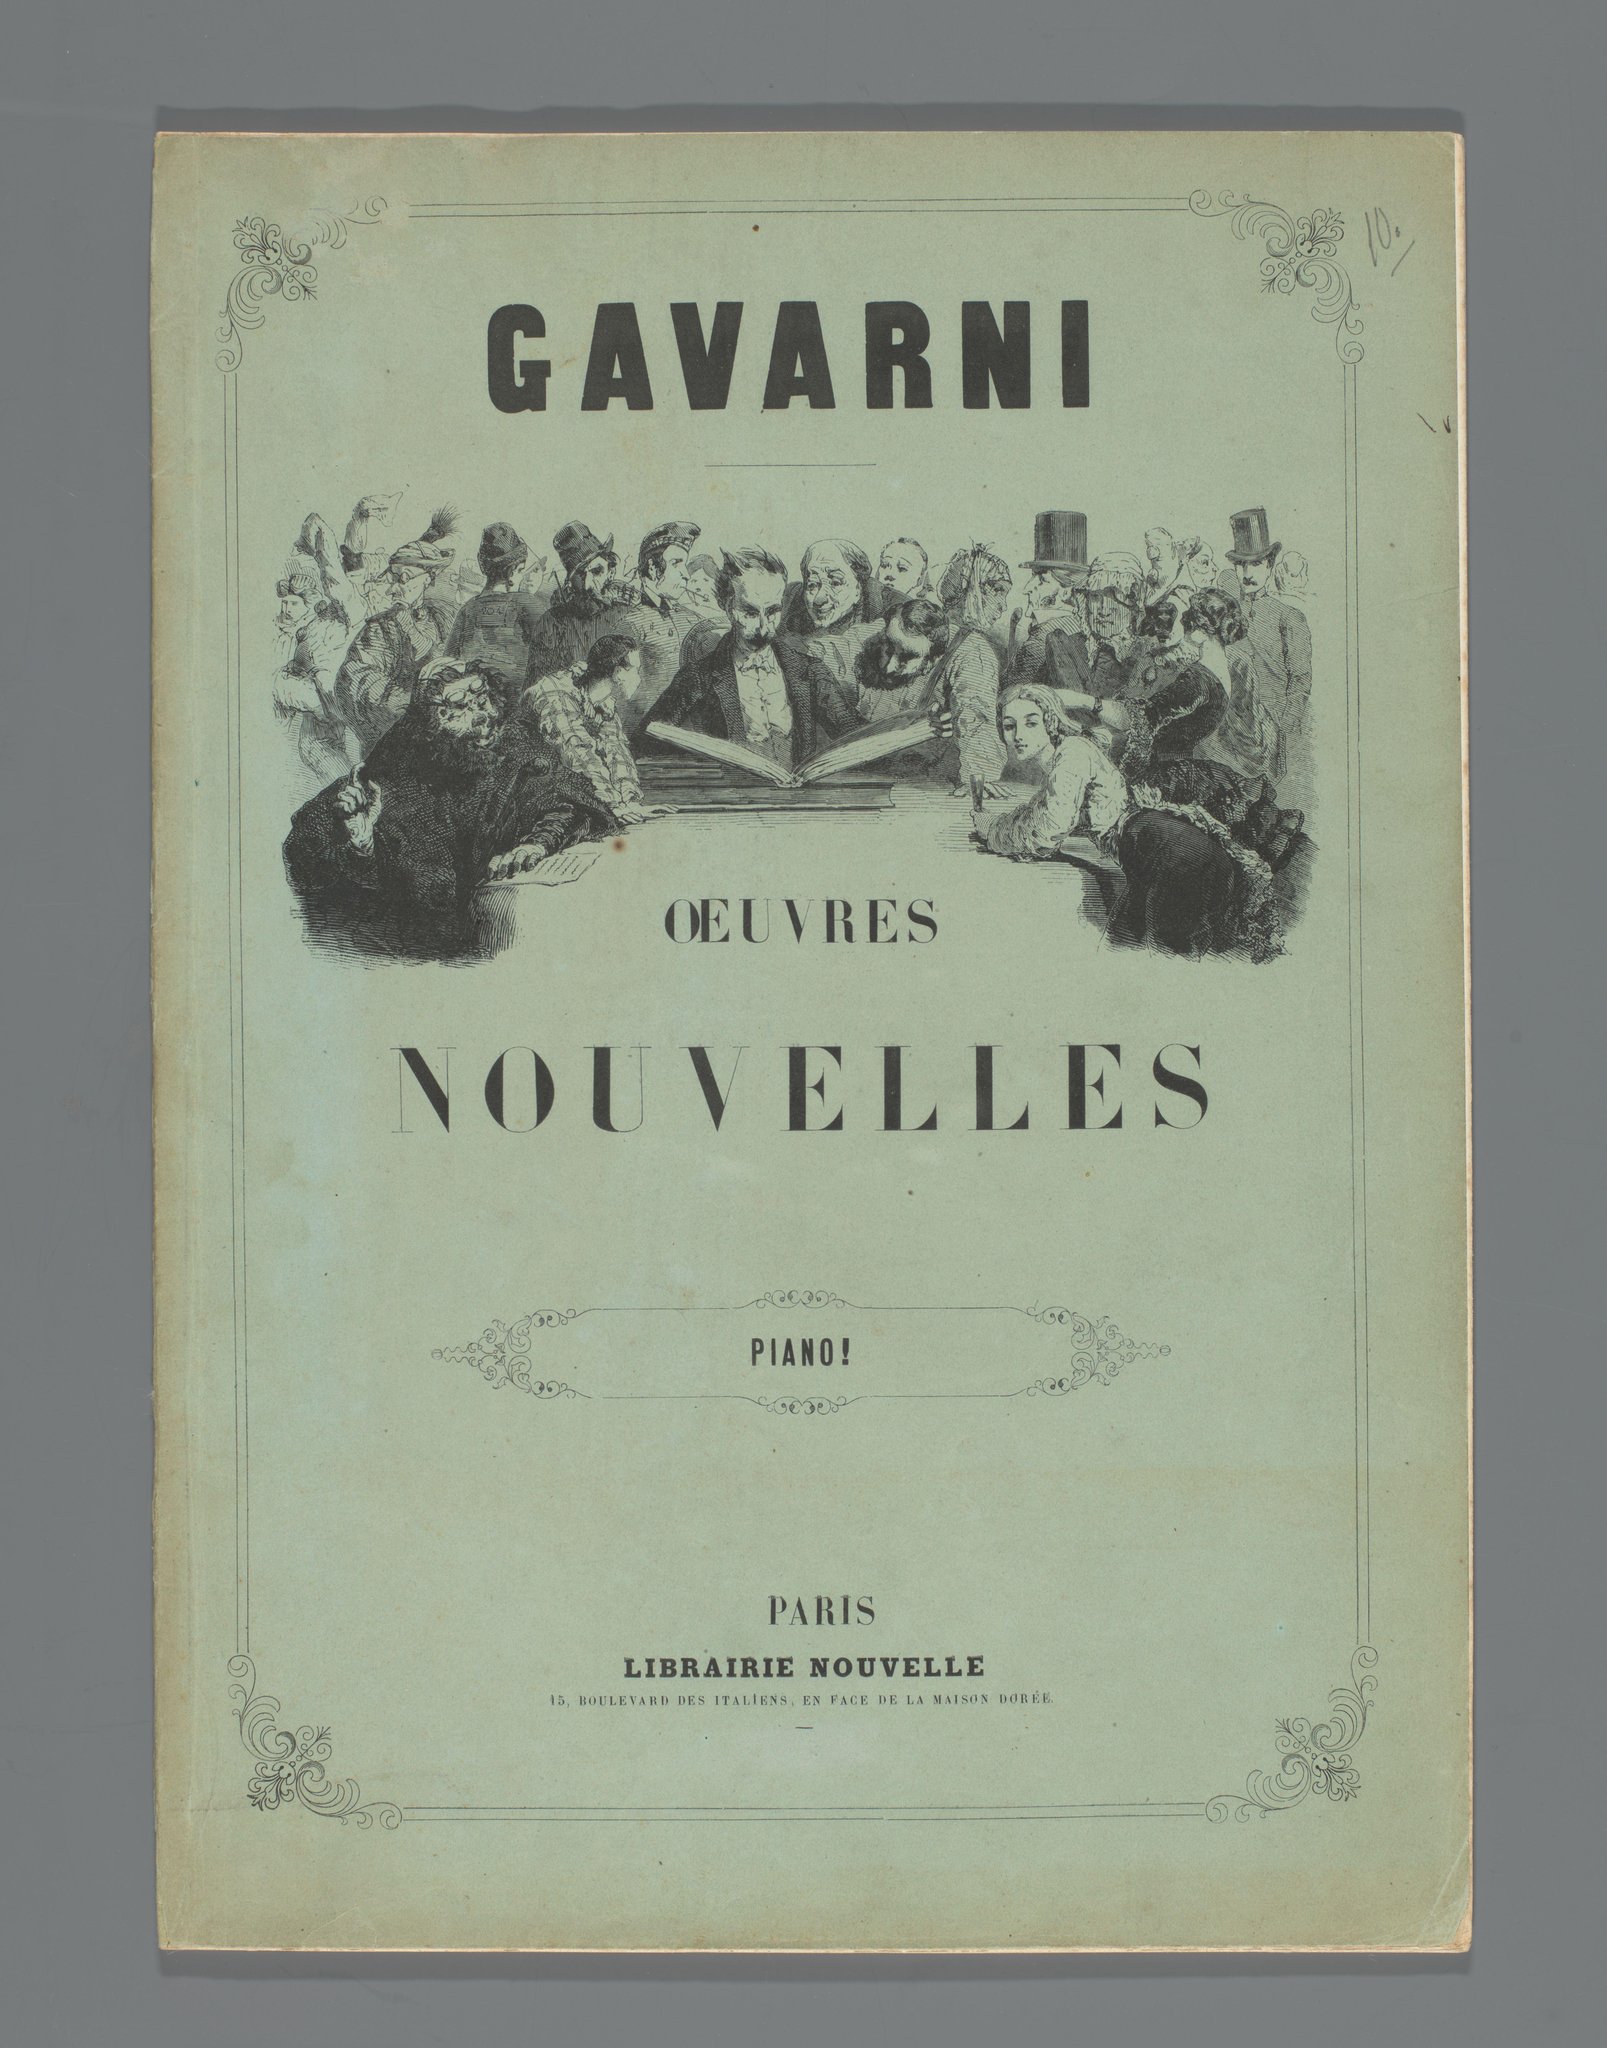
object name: prentrecueil, prentenalbum, prentalbum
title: Pianospel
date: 1853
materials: paper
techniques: lithograph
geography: paris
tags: print, e.g.: engraving, etching, lithograph, art collector, various human types, pianoforte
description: Album met tien prenten op tien bladen. Op de omslag slaat een prentverzamelaar een album open. Hij wordt omringd door verschillende menselijke figuren.